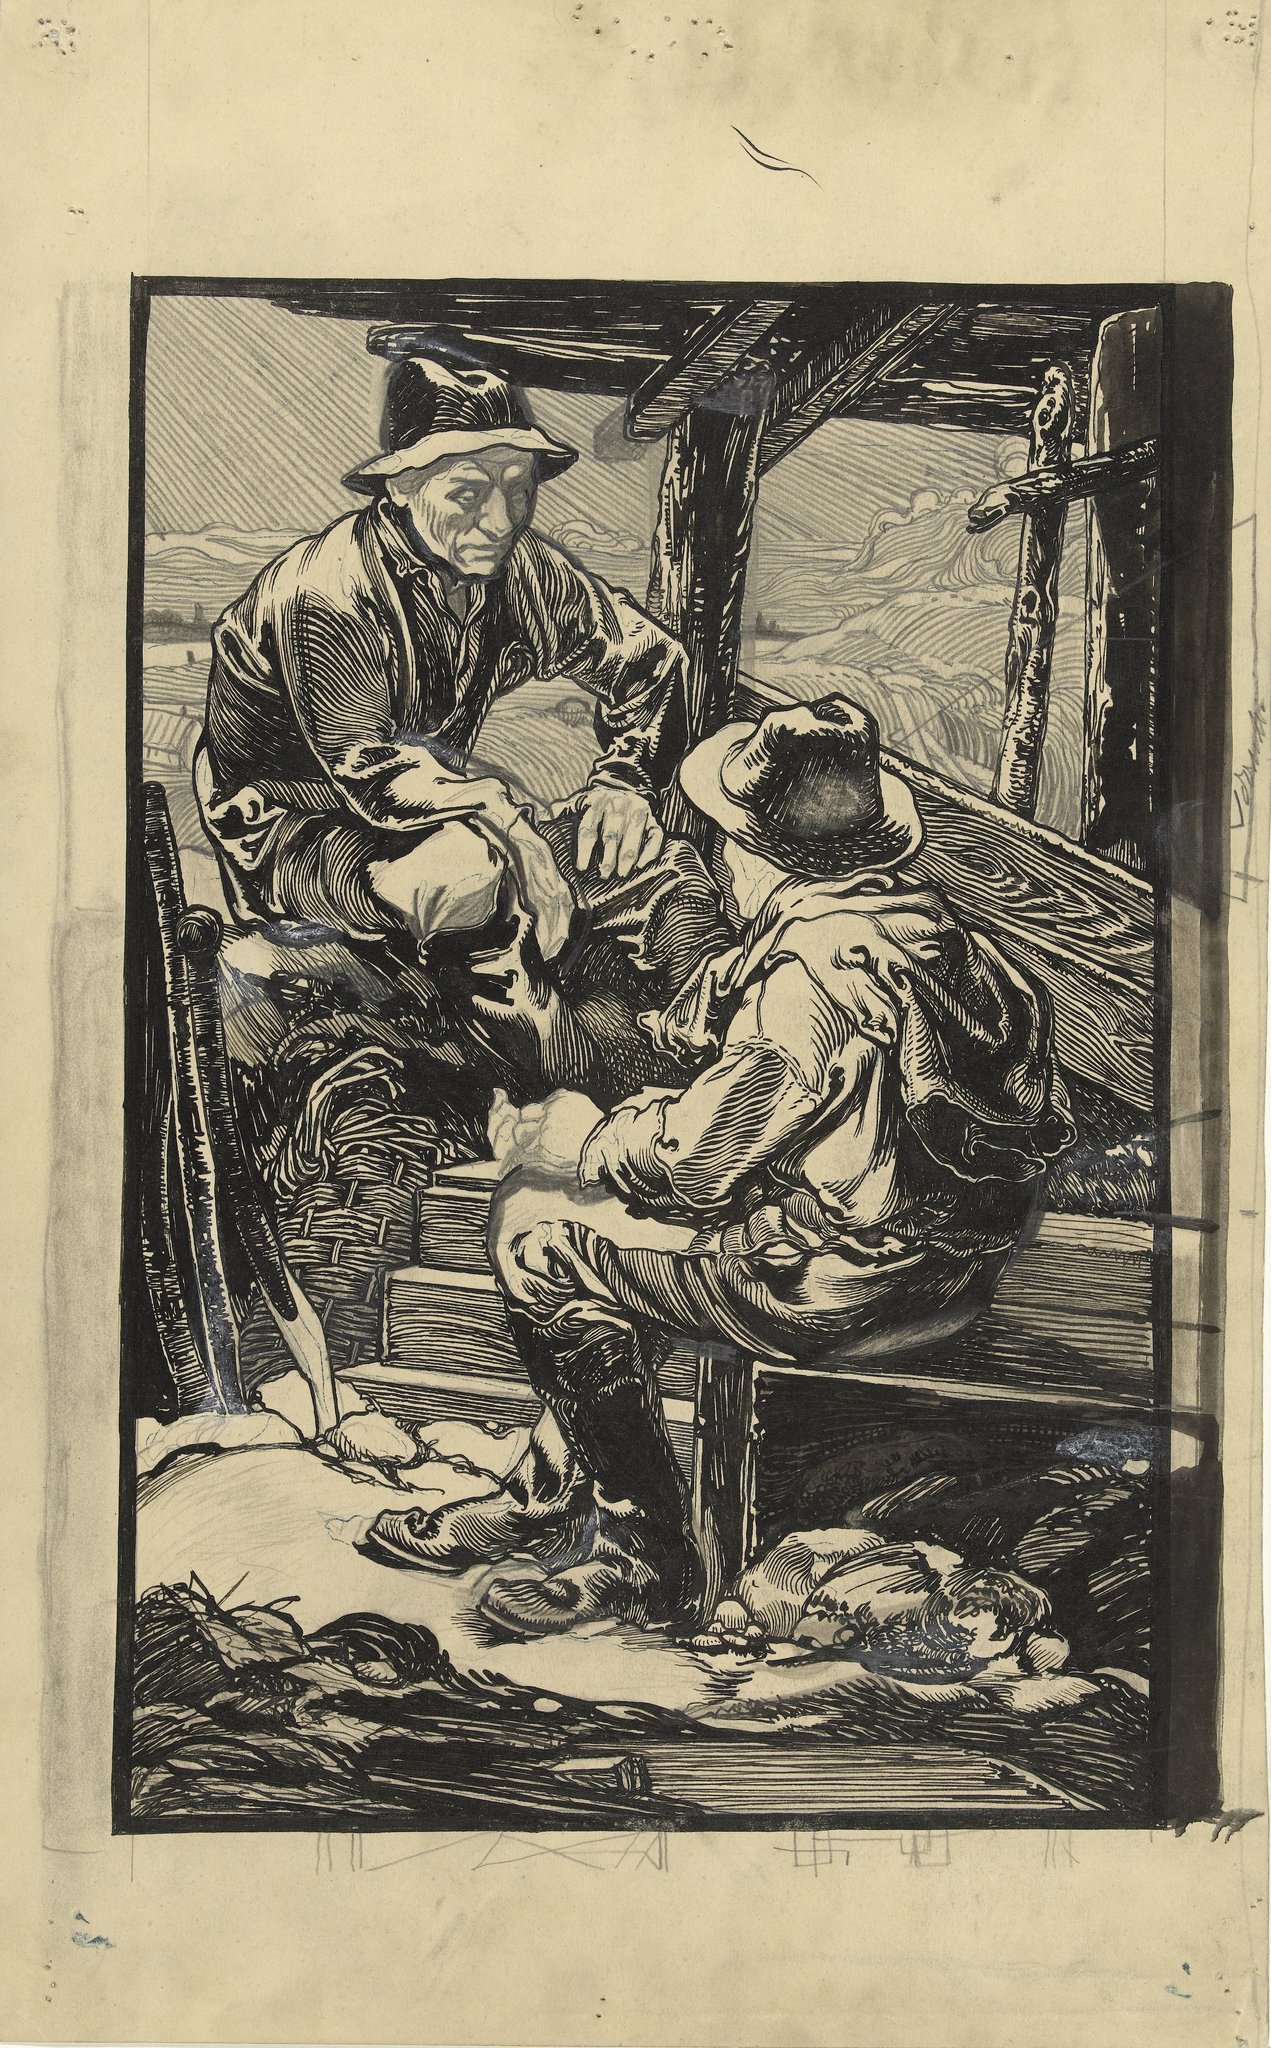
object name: drawing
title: Twee dijkwerkers in een planken hut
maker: johannes josephus aarts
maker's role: draughtsman, print maker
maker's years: 1871-1934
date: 1881-1934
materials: charcoal, paint, ink, paper, pencil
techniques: brush, pen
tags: heaping up (industrial process), dikes, levee